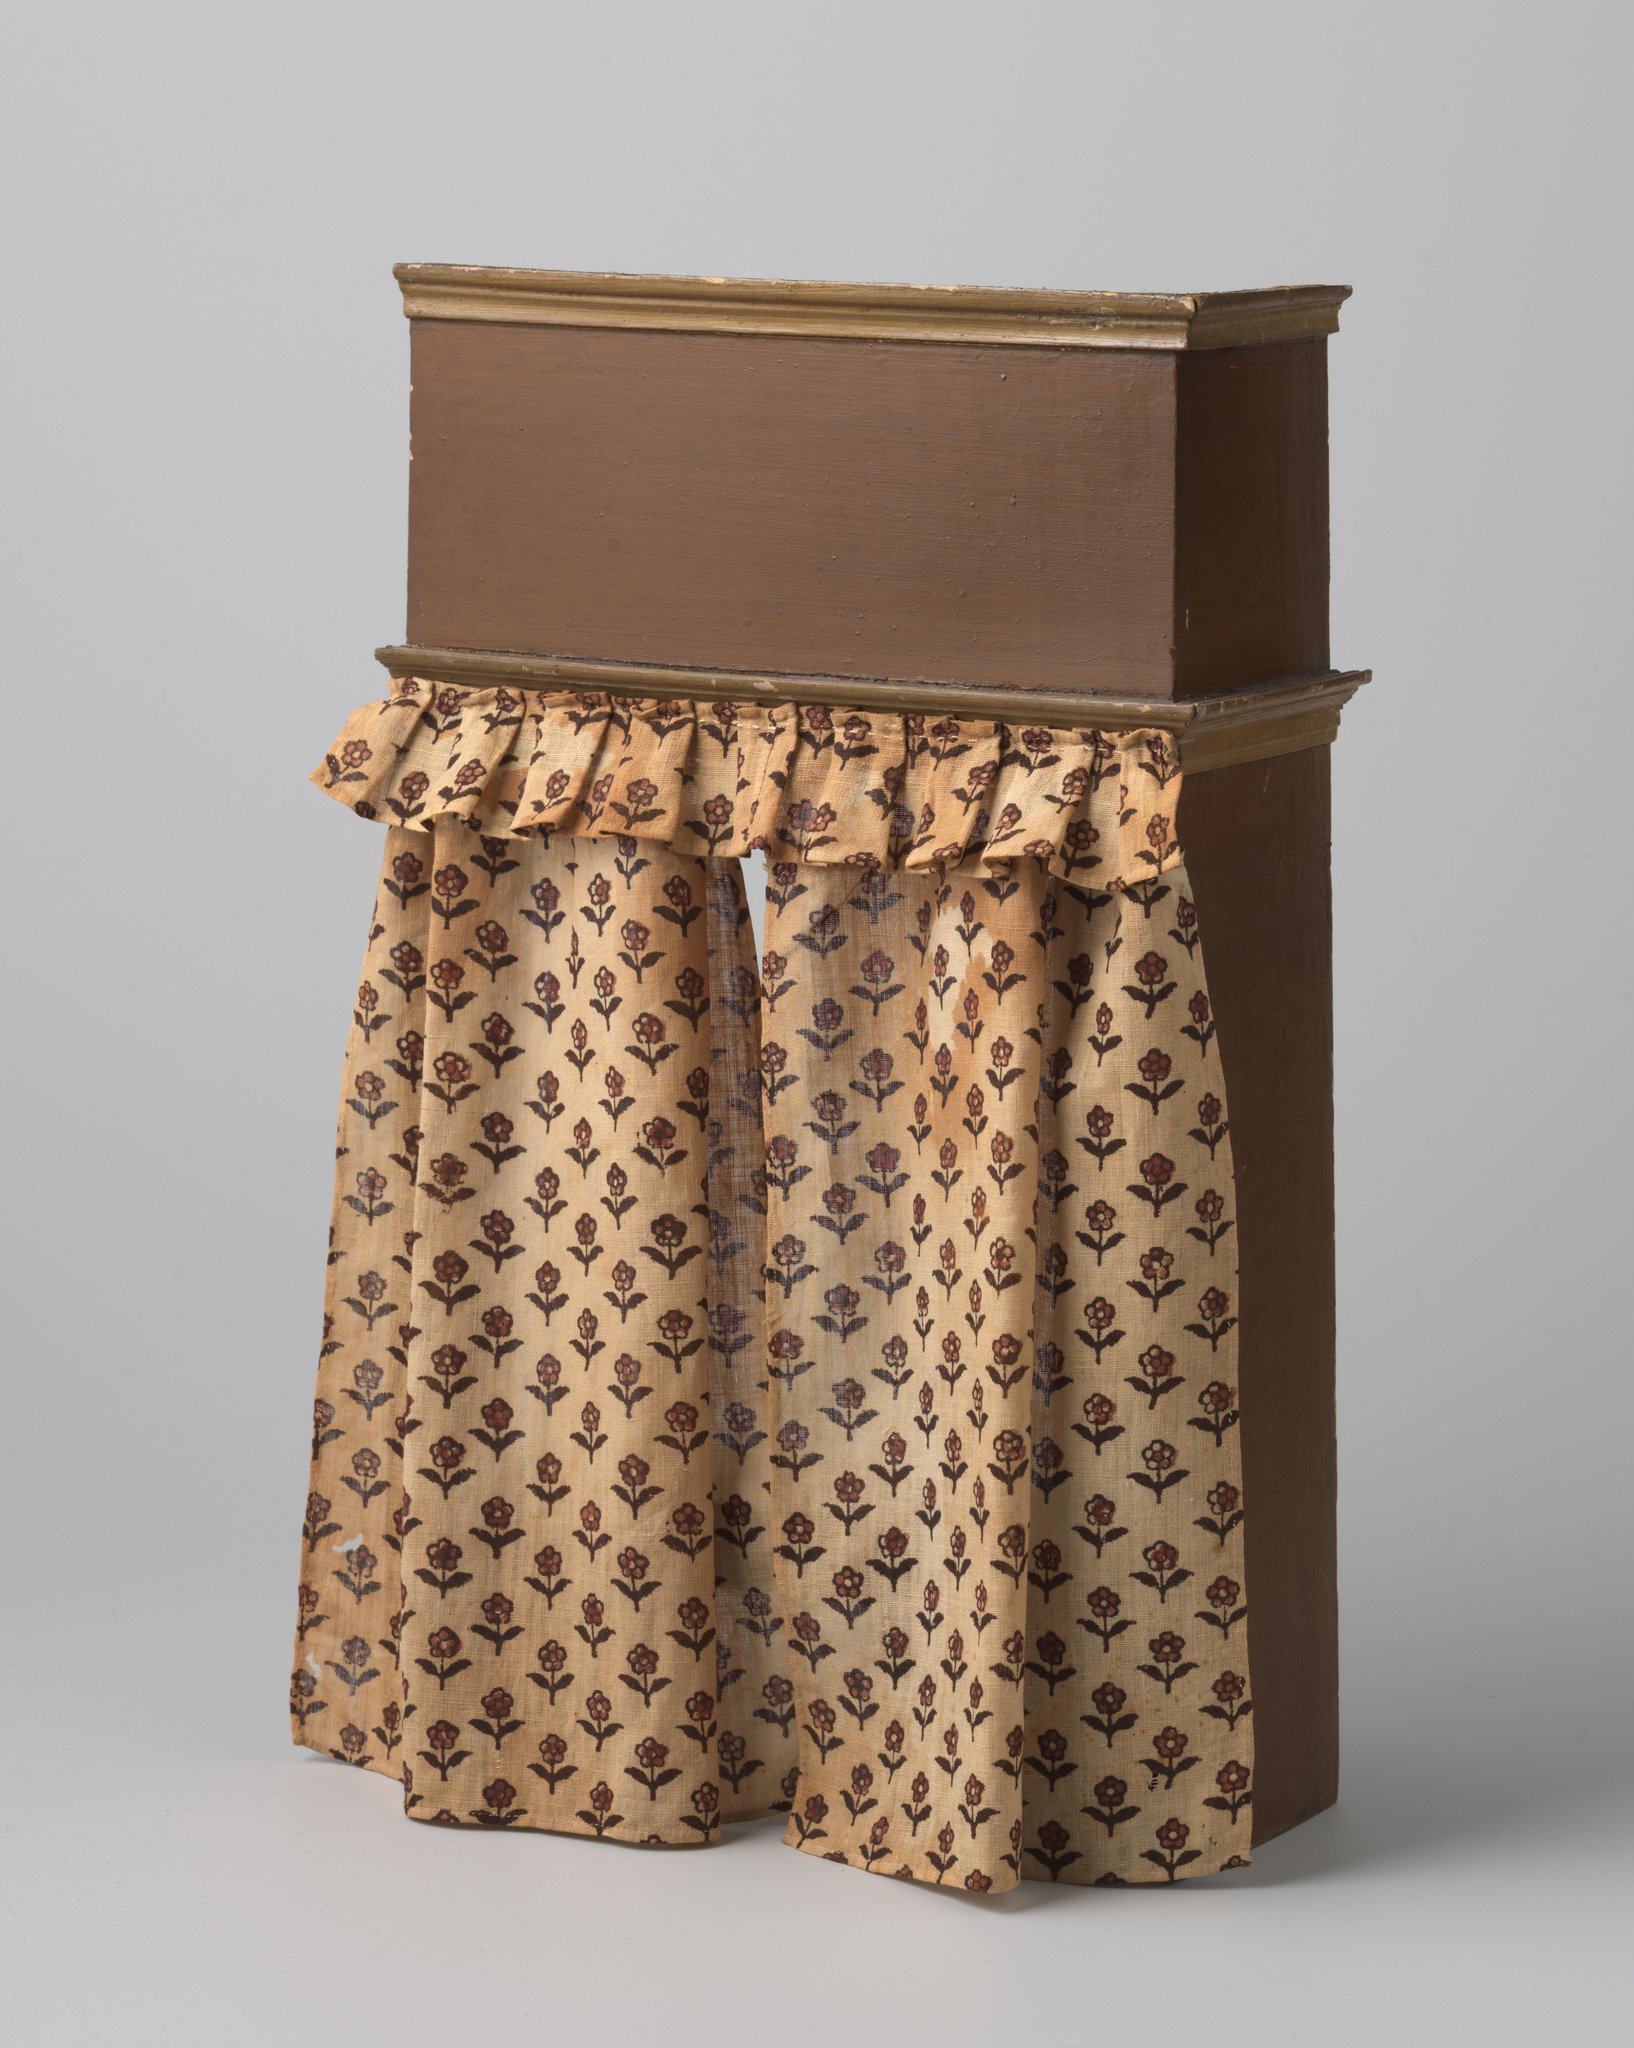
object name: miniature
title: Gordijn van bedstede, van bedrukte katoen.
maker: Anonymous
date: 1690-1710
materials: copper, cotton, linen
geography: india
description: Gordijn voor een bedstede, vervaardigd van bedrukte katoen met verspringend motief van bloem op steeltje, zwart rood op witte achtergrond. De gordijn hangt met bandjes die door koperen ringen zijn gehaald, aan een koperen roede met oog aan één zijde. Door ringen beurtelings gedraaid aan roede te schuiven ontstaan de plooien in de gordijnen.